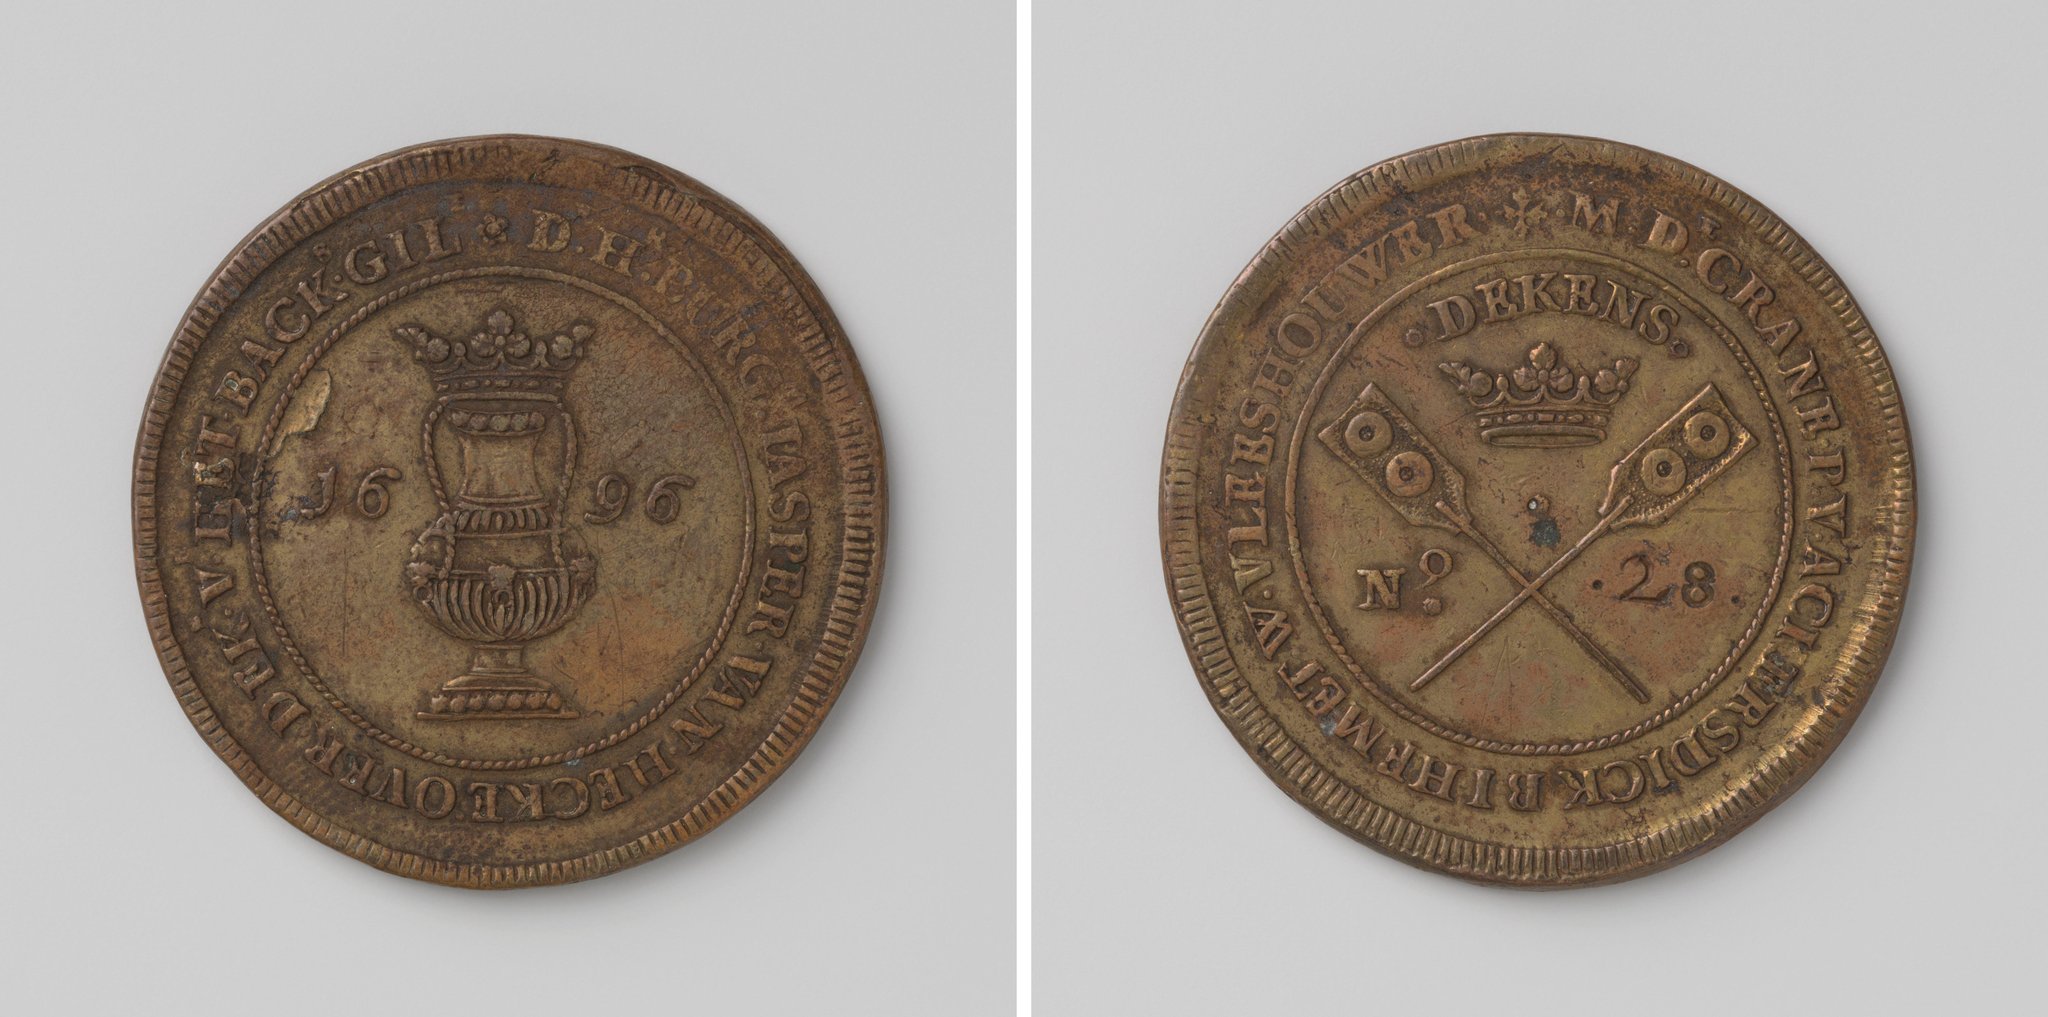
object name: medal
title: Bakkersgilde van Vlissingen, gildepenning met no. 28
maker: Anonymous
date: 1696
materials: brass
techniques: engraving, striking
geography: flushing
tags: flushing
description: Messing penning. Voorzijde: gekroonde fles tussen jaartal binnen omschrift. Keerzijde: twee kruislings geplaatste bakkersschoten onder kroon en opschrift tussen cijfer No. 28 binnen omschrift